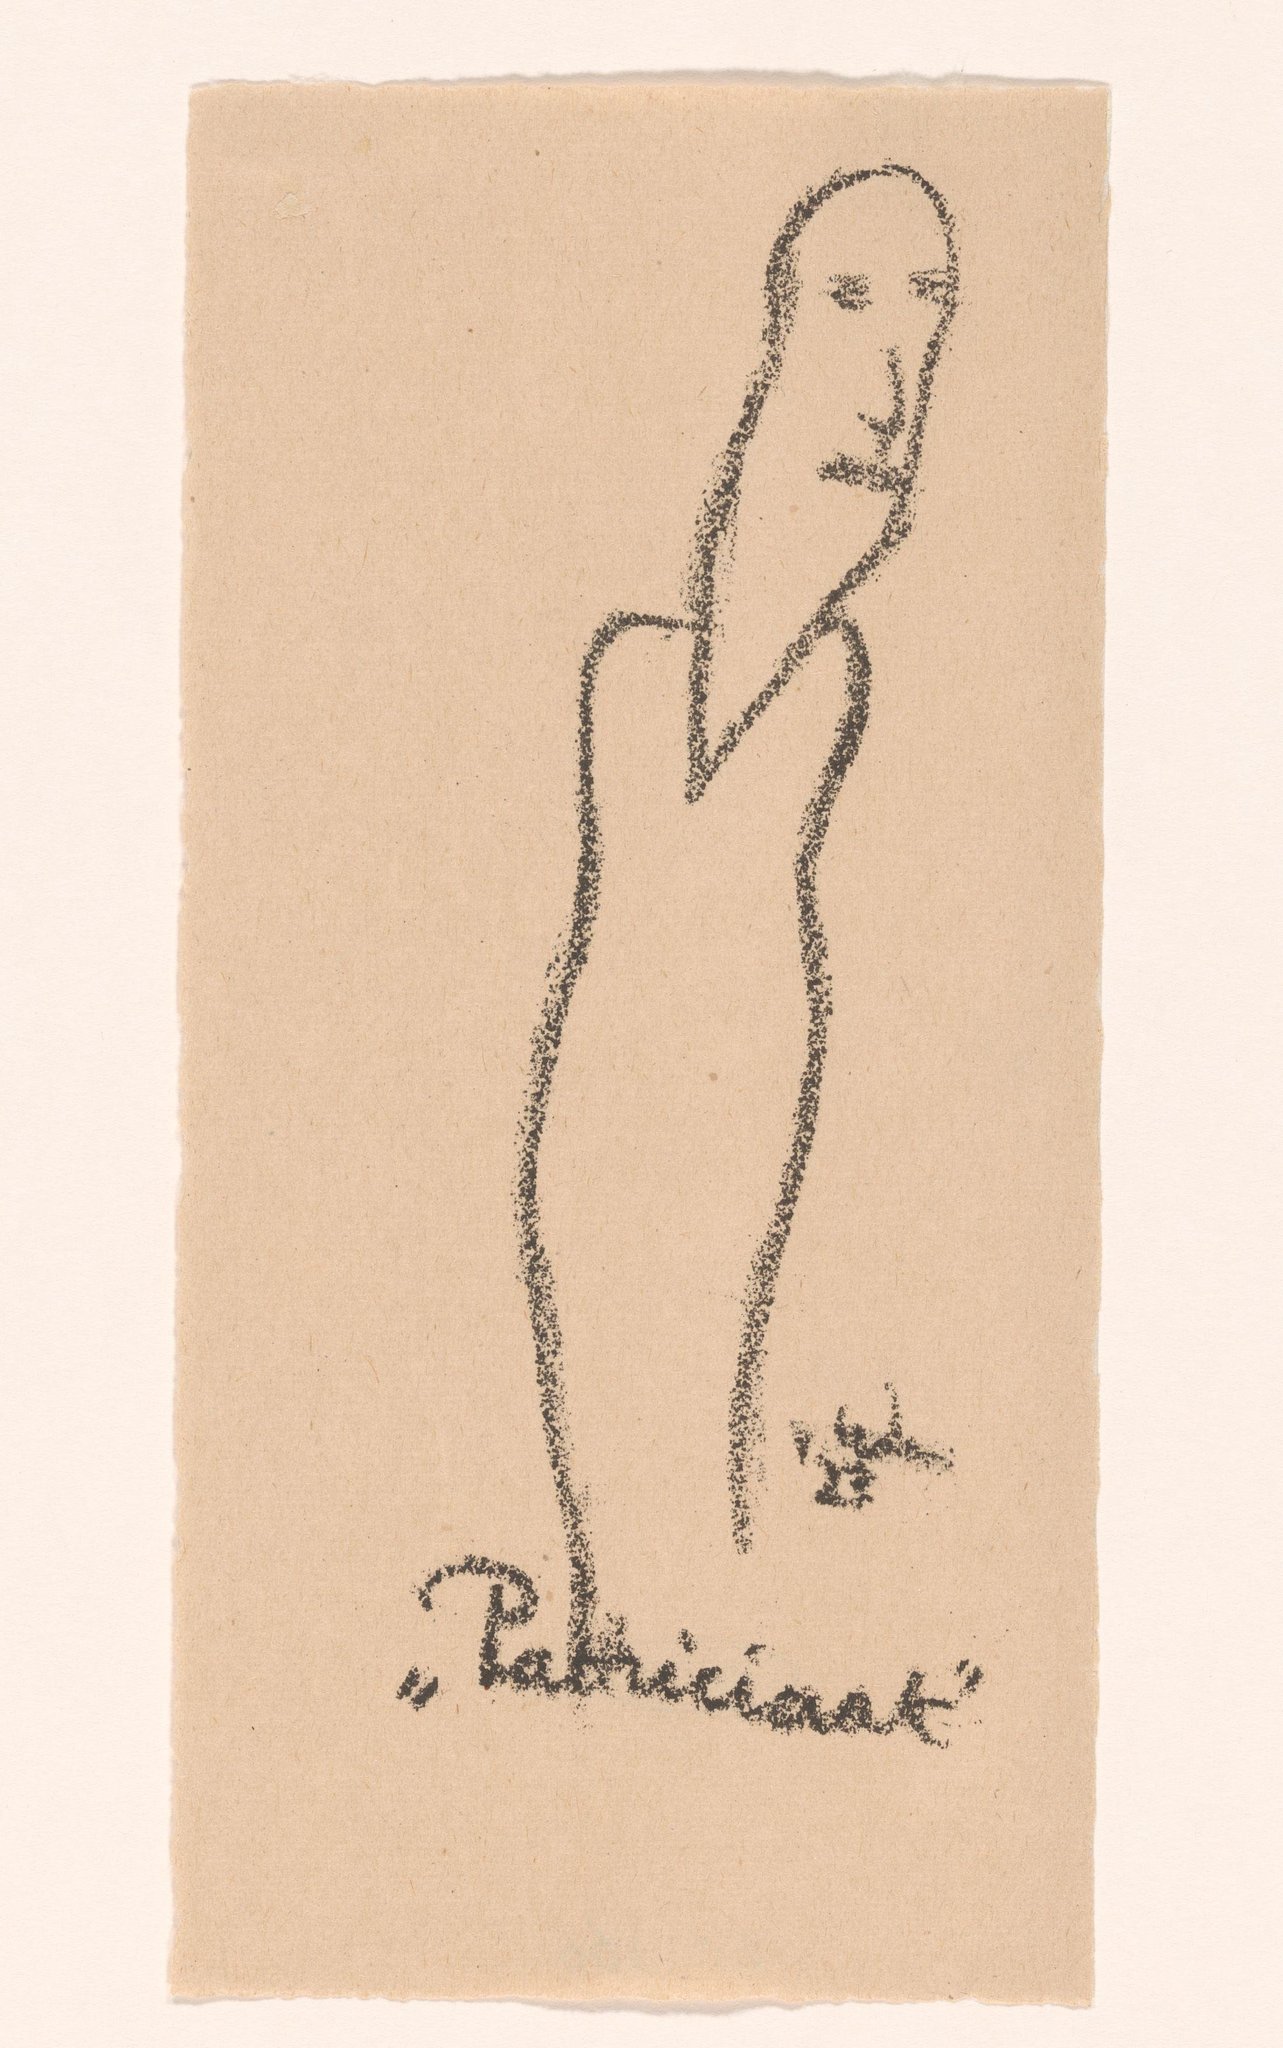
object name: print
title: Idealisten II en verdere Kanttekeningen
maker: erich wichmann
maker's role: print maker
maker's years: 1890-1929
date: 1923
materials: paper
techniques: lithograph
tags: caricatures (human types), nobility and patriciate; chivalry, knighthood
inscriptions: collector's mark: Lugt 2228